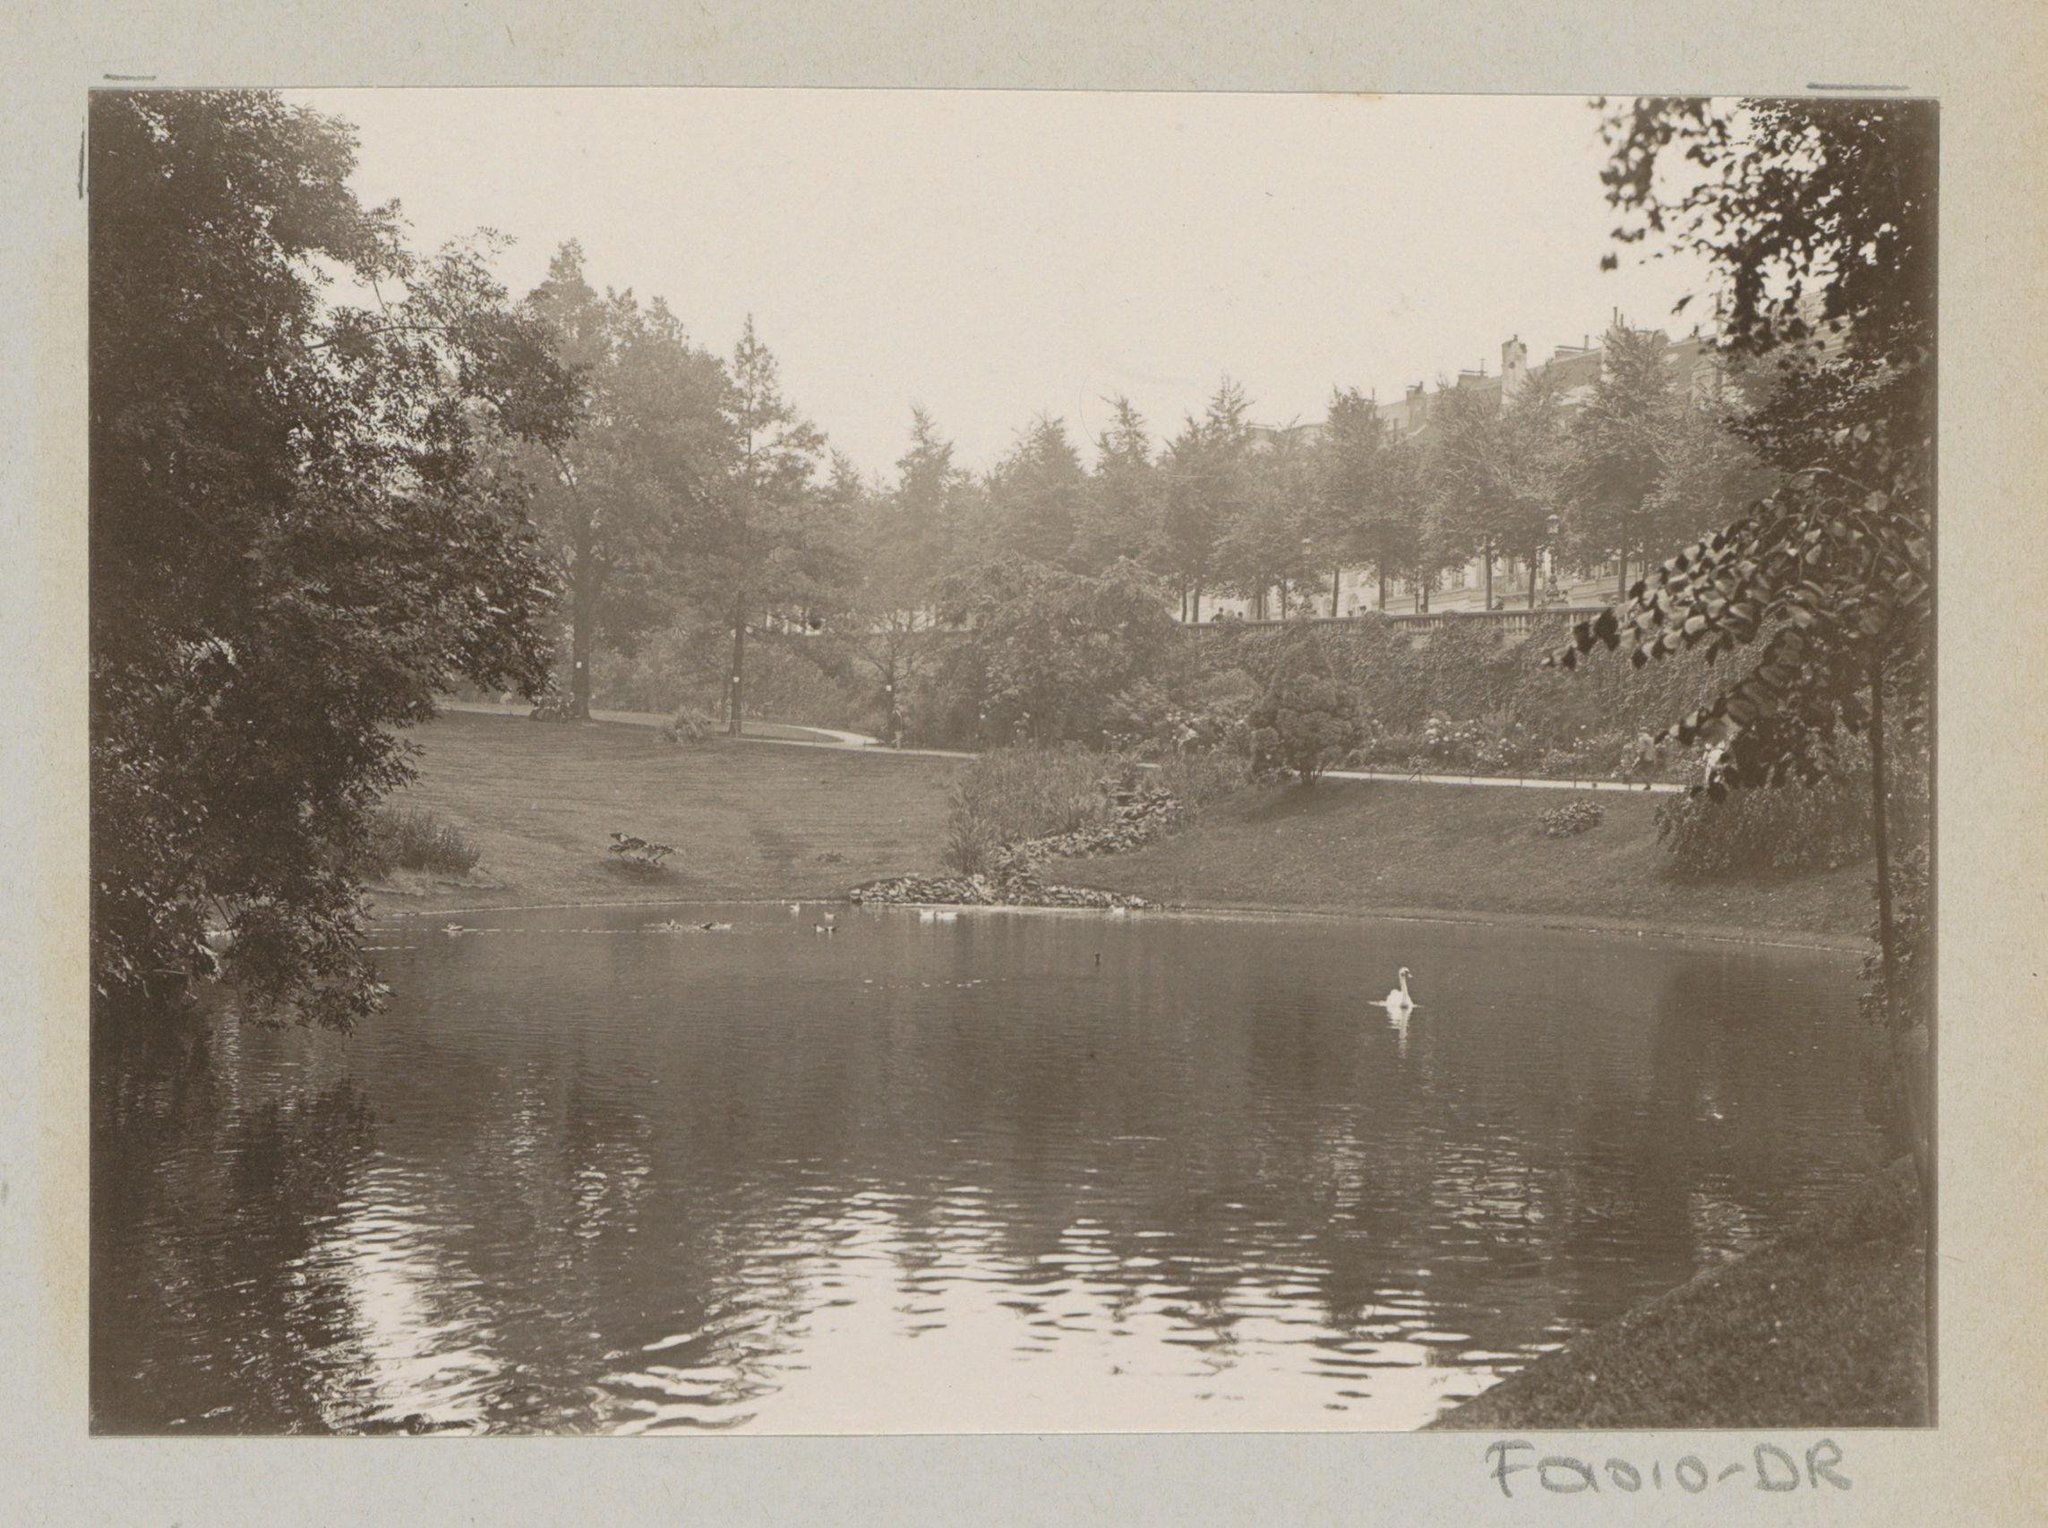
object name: photograph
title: Vijver in een park, vermoedelijk te Laken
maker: Anonymous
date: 1900-1910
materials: photographic support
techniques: matte daylight collodion silver print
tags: trees, pond, public gardens, park, laeken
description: Onderdeel van Familiealbum met onder meer foto's van Wijnhandel Kraaij & Co. Bordeaux-Amsterdam.